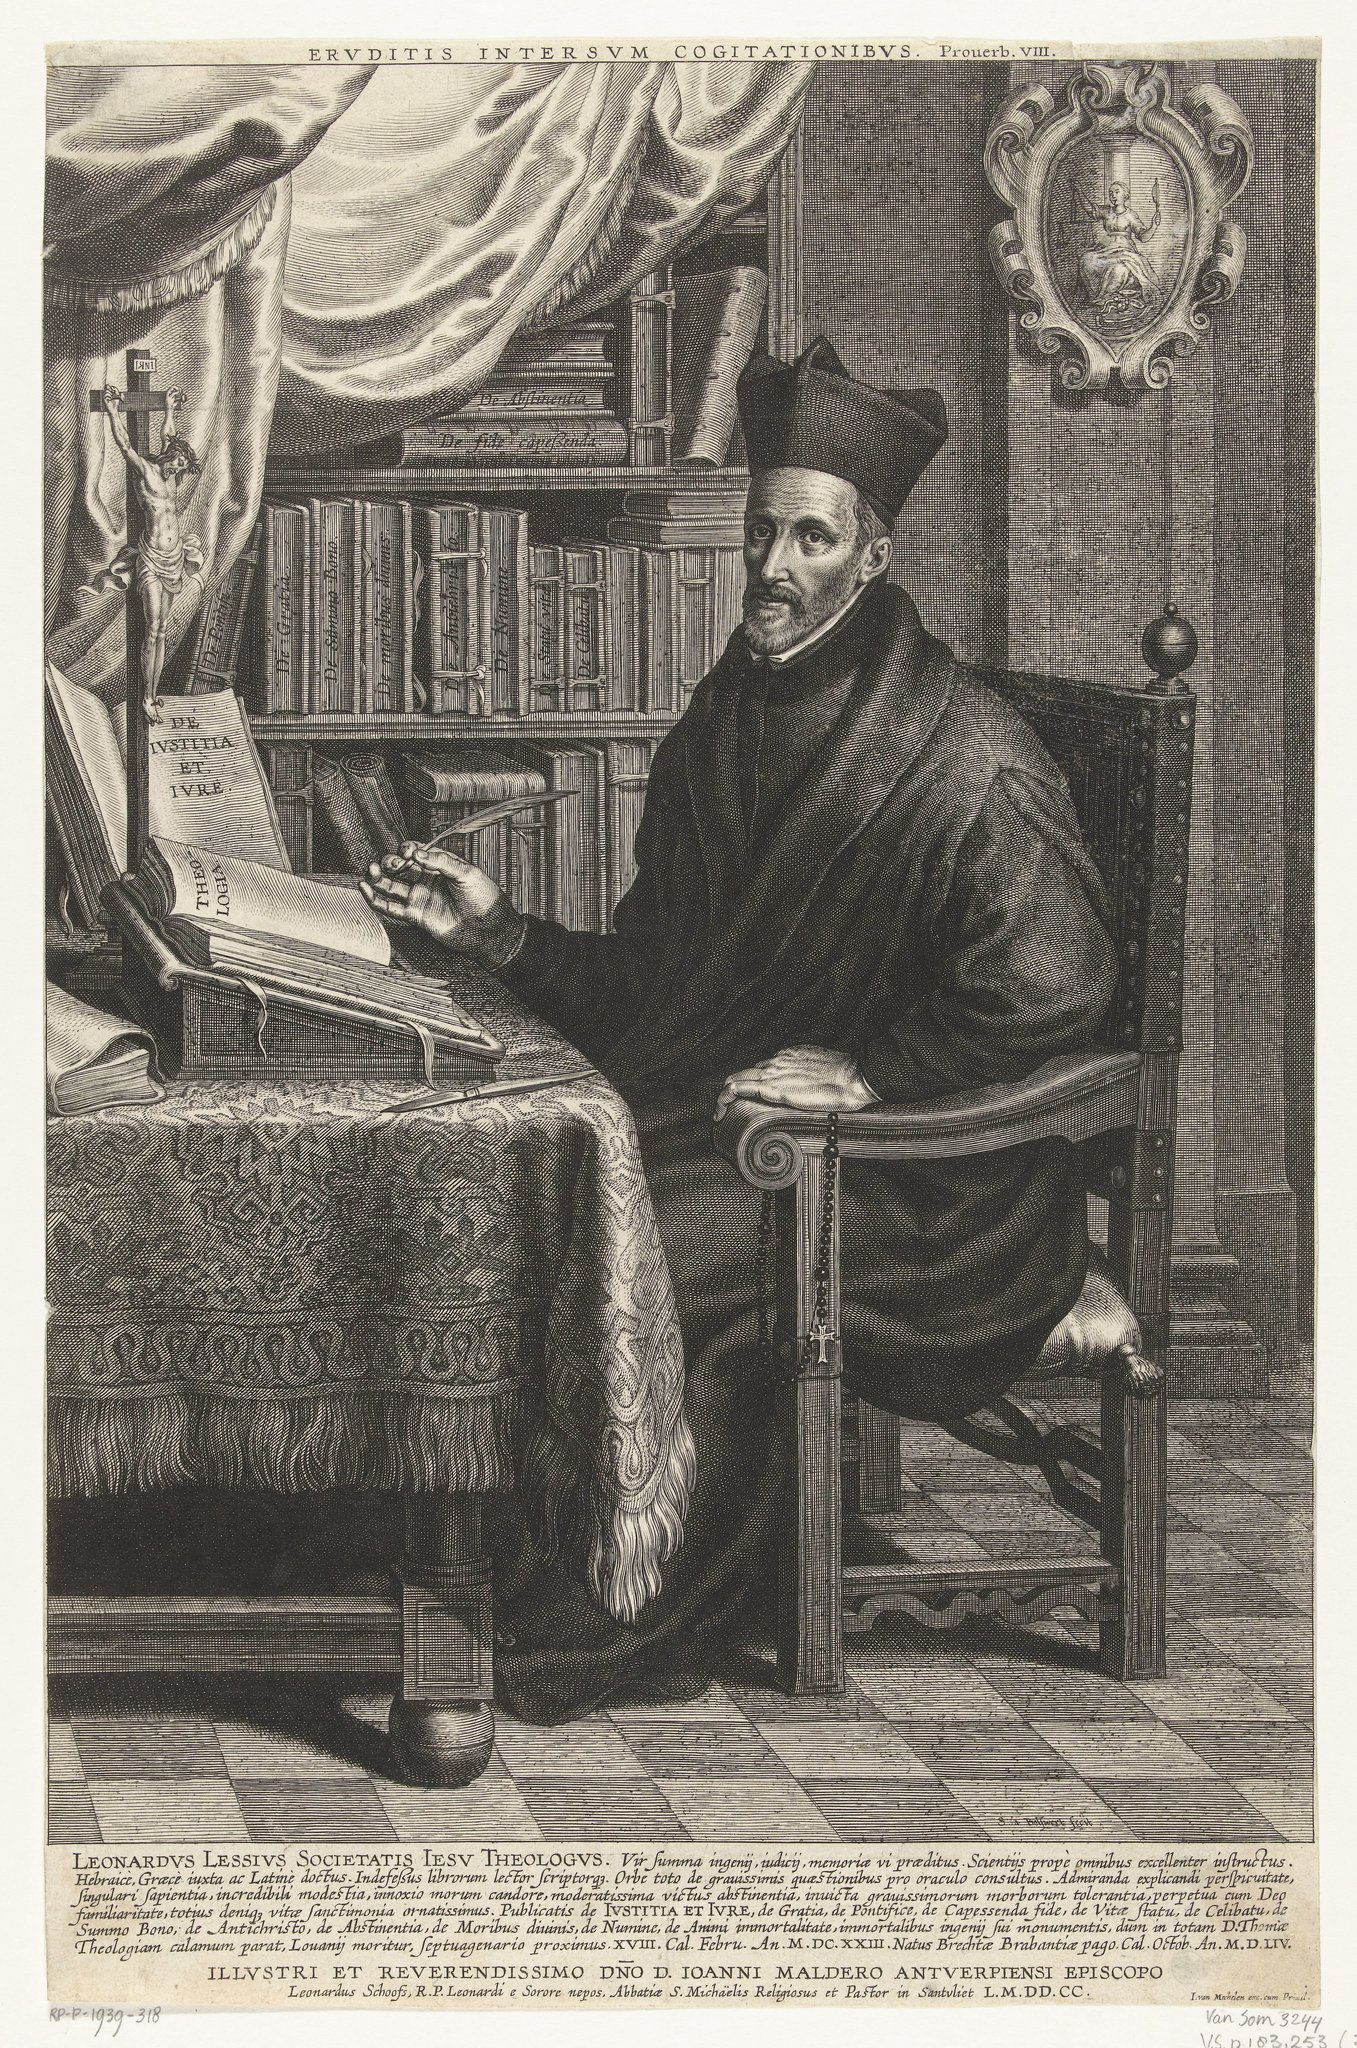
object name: print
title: Leonardvs Lessivs Societatis Iesv Theologvs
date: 1623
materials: paper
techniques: engraving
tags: louvain, theologian in his study (writing or reading)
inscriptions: collector's mark: Lugt 151, inscription: ‘Vir summa ingenij, ... pago Cal. octob. An. M.D.LIV.’, collector's mark: Lugt 2760, collector's mark: Lugt 2228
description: Portret van jezuïet Leonardus Lessius (Lenaert Leys) in zijn studeervertrek. De man zit aan een tafel en schrijft een boek. Boven het portret staat een bijbeltekst: Eruditis Intersum cogitationibus (Spreuken 8, wijsheid schuilt in geleerde gedachten). Onder de voorstelling staat een opsomming van gedenkwaardige feiten betreffende deze theoloog.